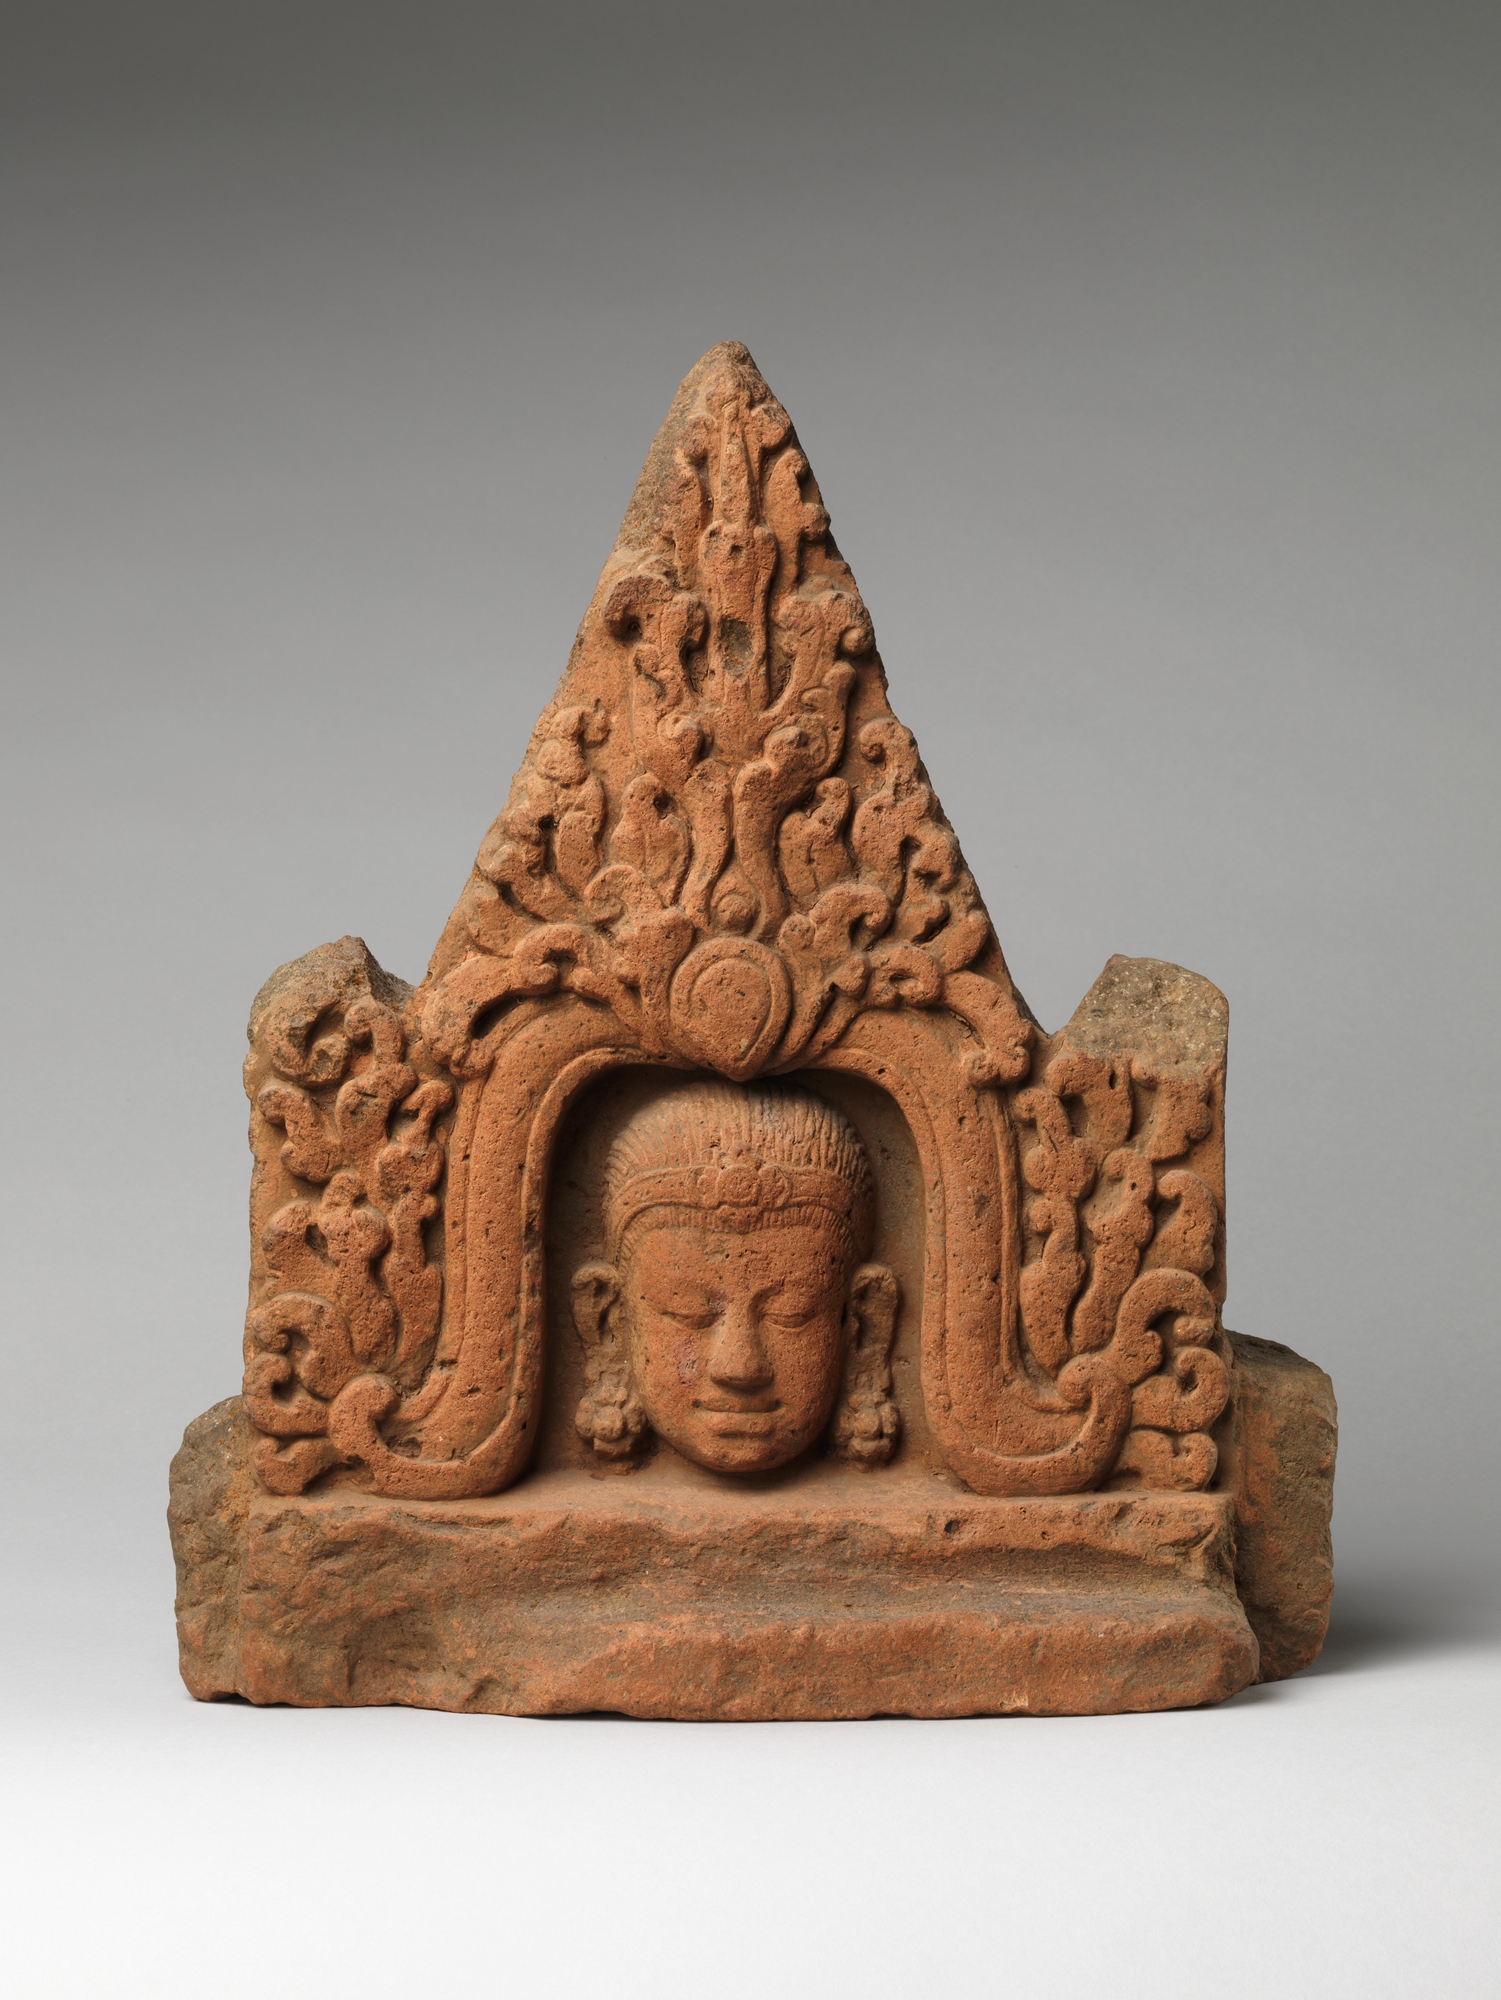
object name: antefix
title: Antefix with Face of a Deity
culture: indonesian, javanese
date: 801-1000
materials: terracotta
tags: faces